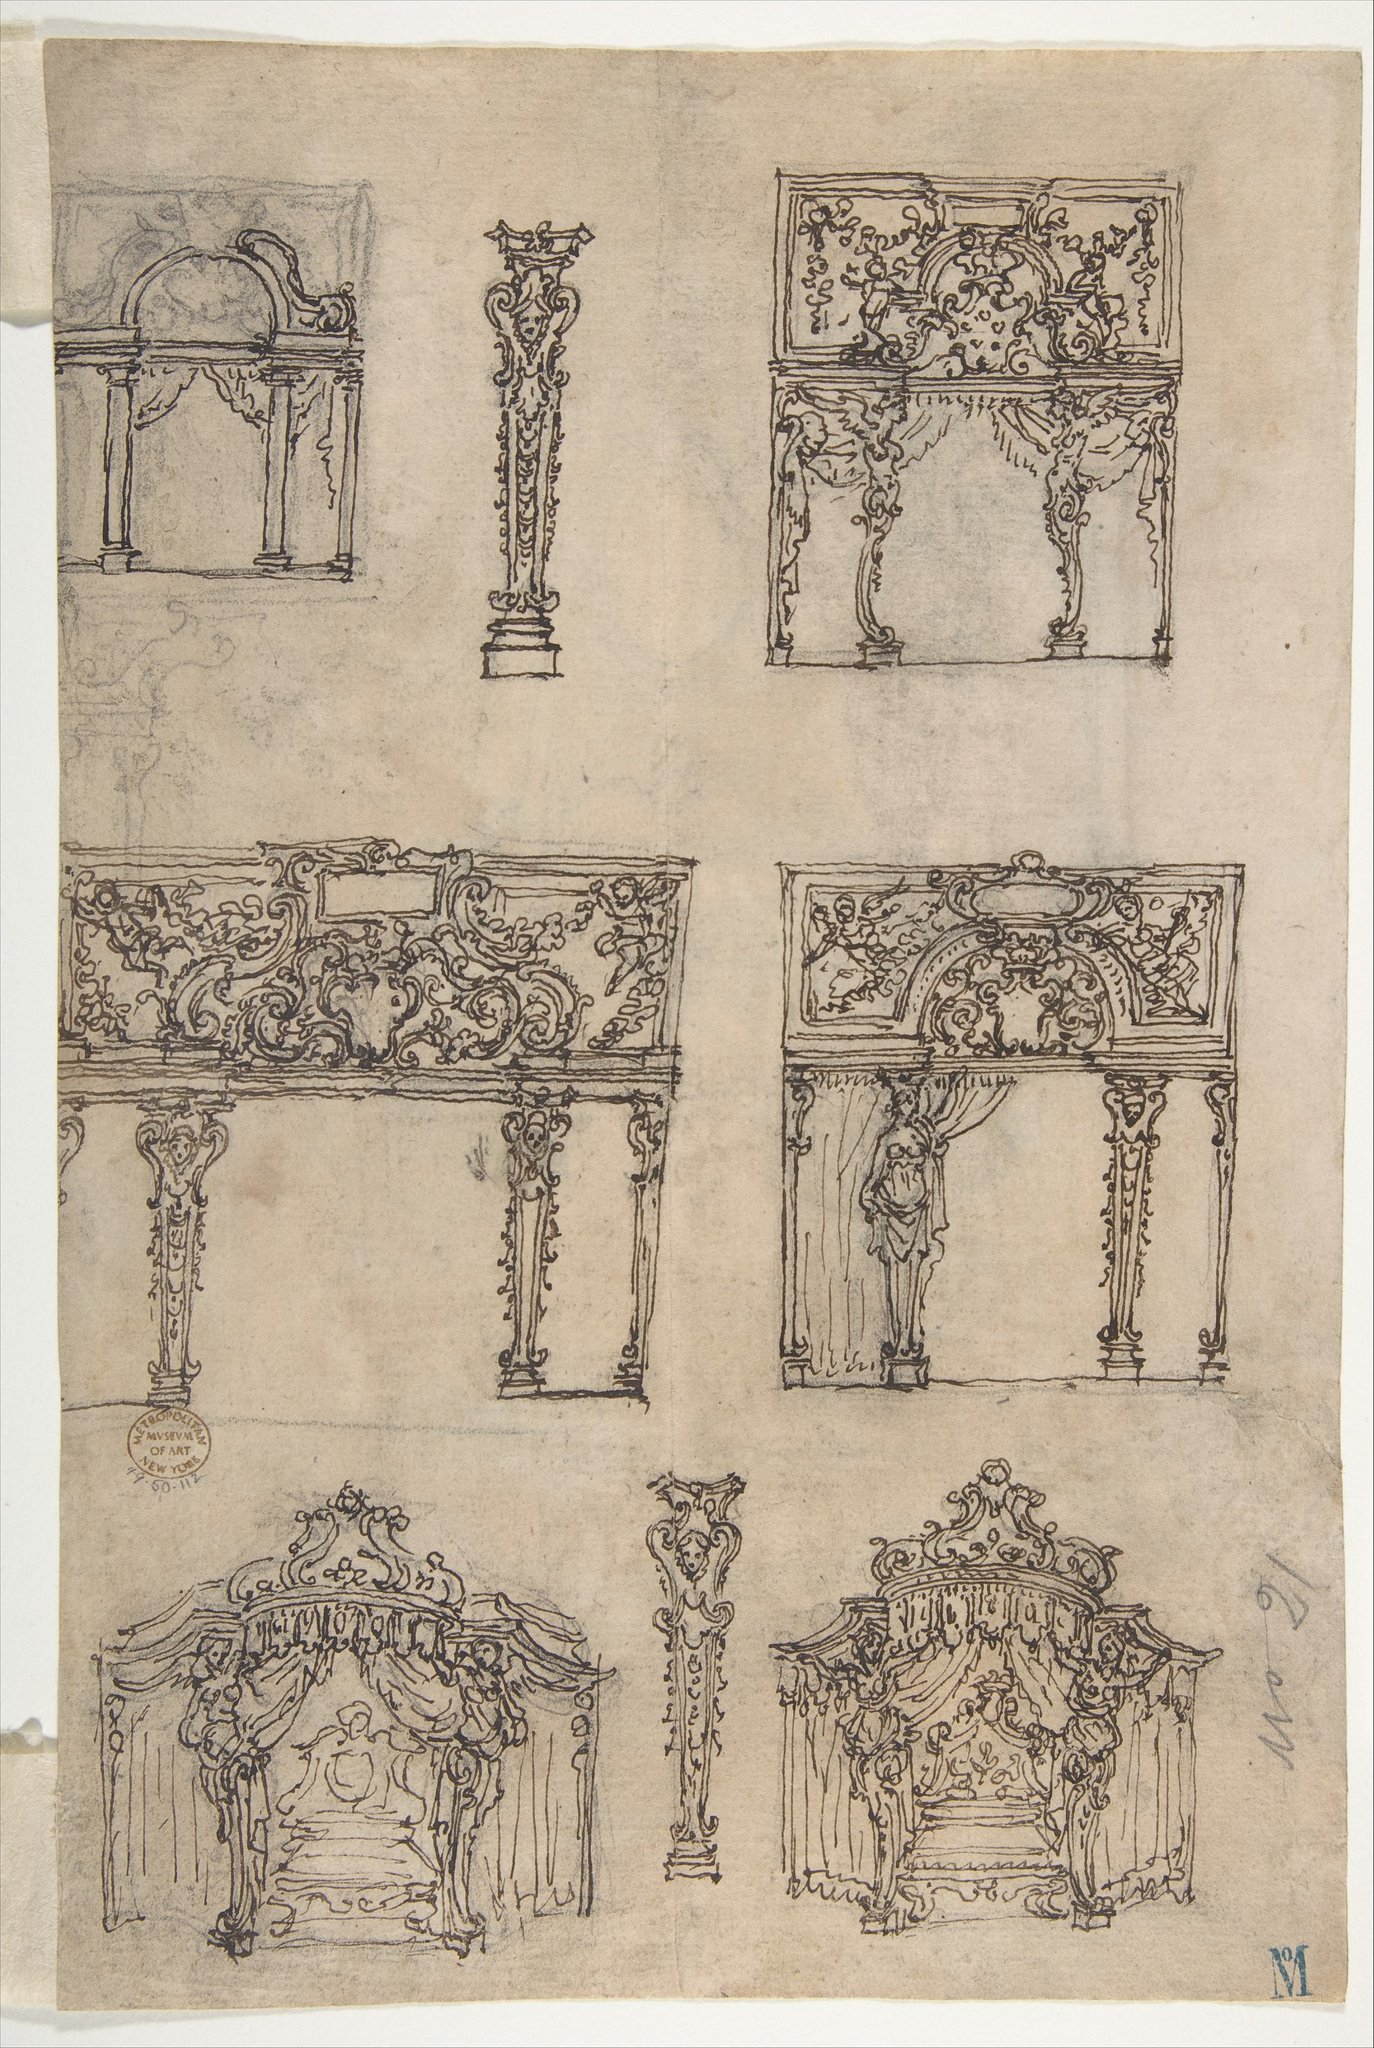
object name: drawing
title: Designs for Archways and Baldachins with Caryatids and Coats of Arms (recto); Design for a Monument with Statues of Prudence and Fortitude (verso)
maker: giovanni battista foggini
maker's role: artist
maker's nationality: italian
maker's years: 1652-1725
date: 1672-1725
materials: chalk, graphite, ink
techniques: pen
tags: monuments,caryatids,coat of arms